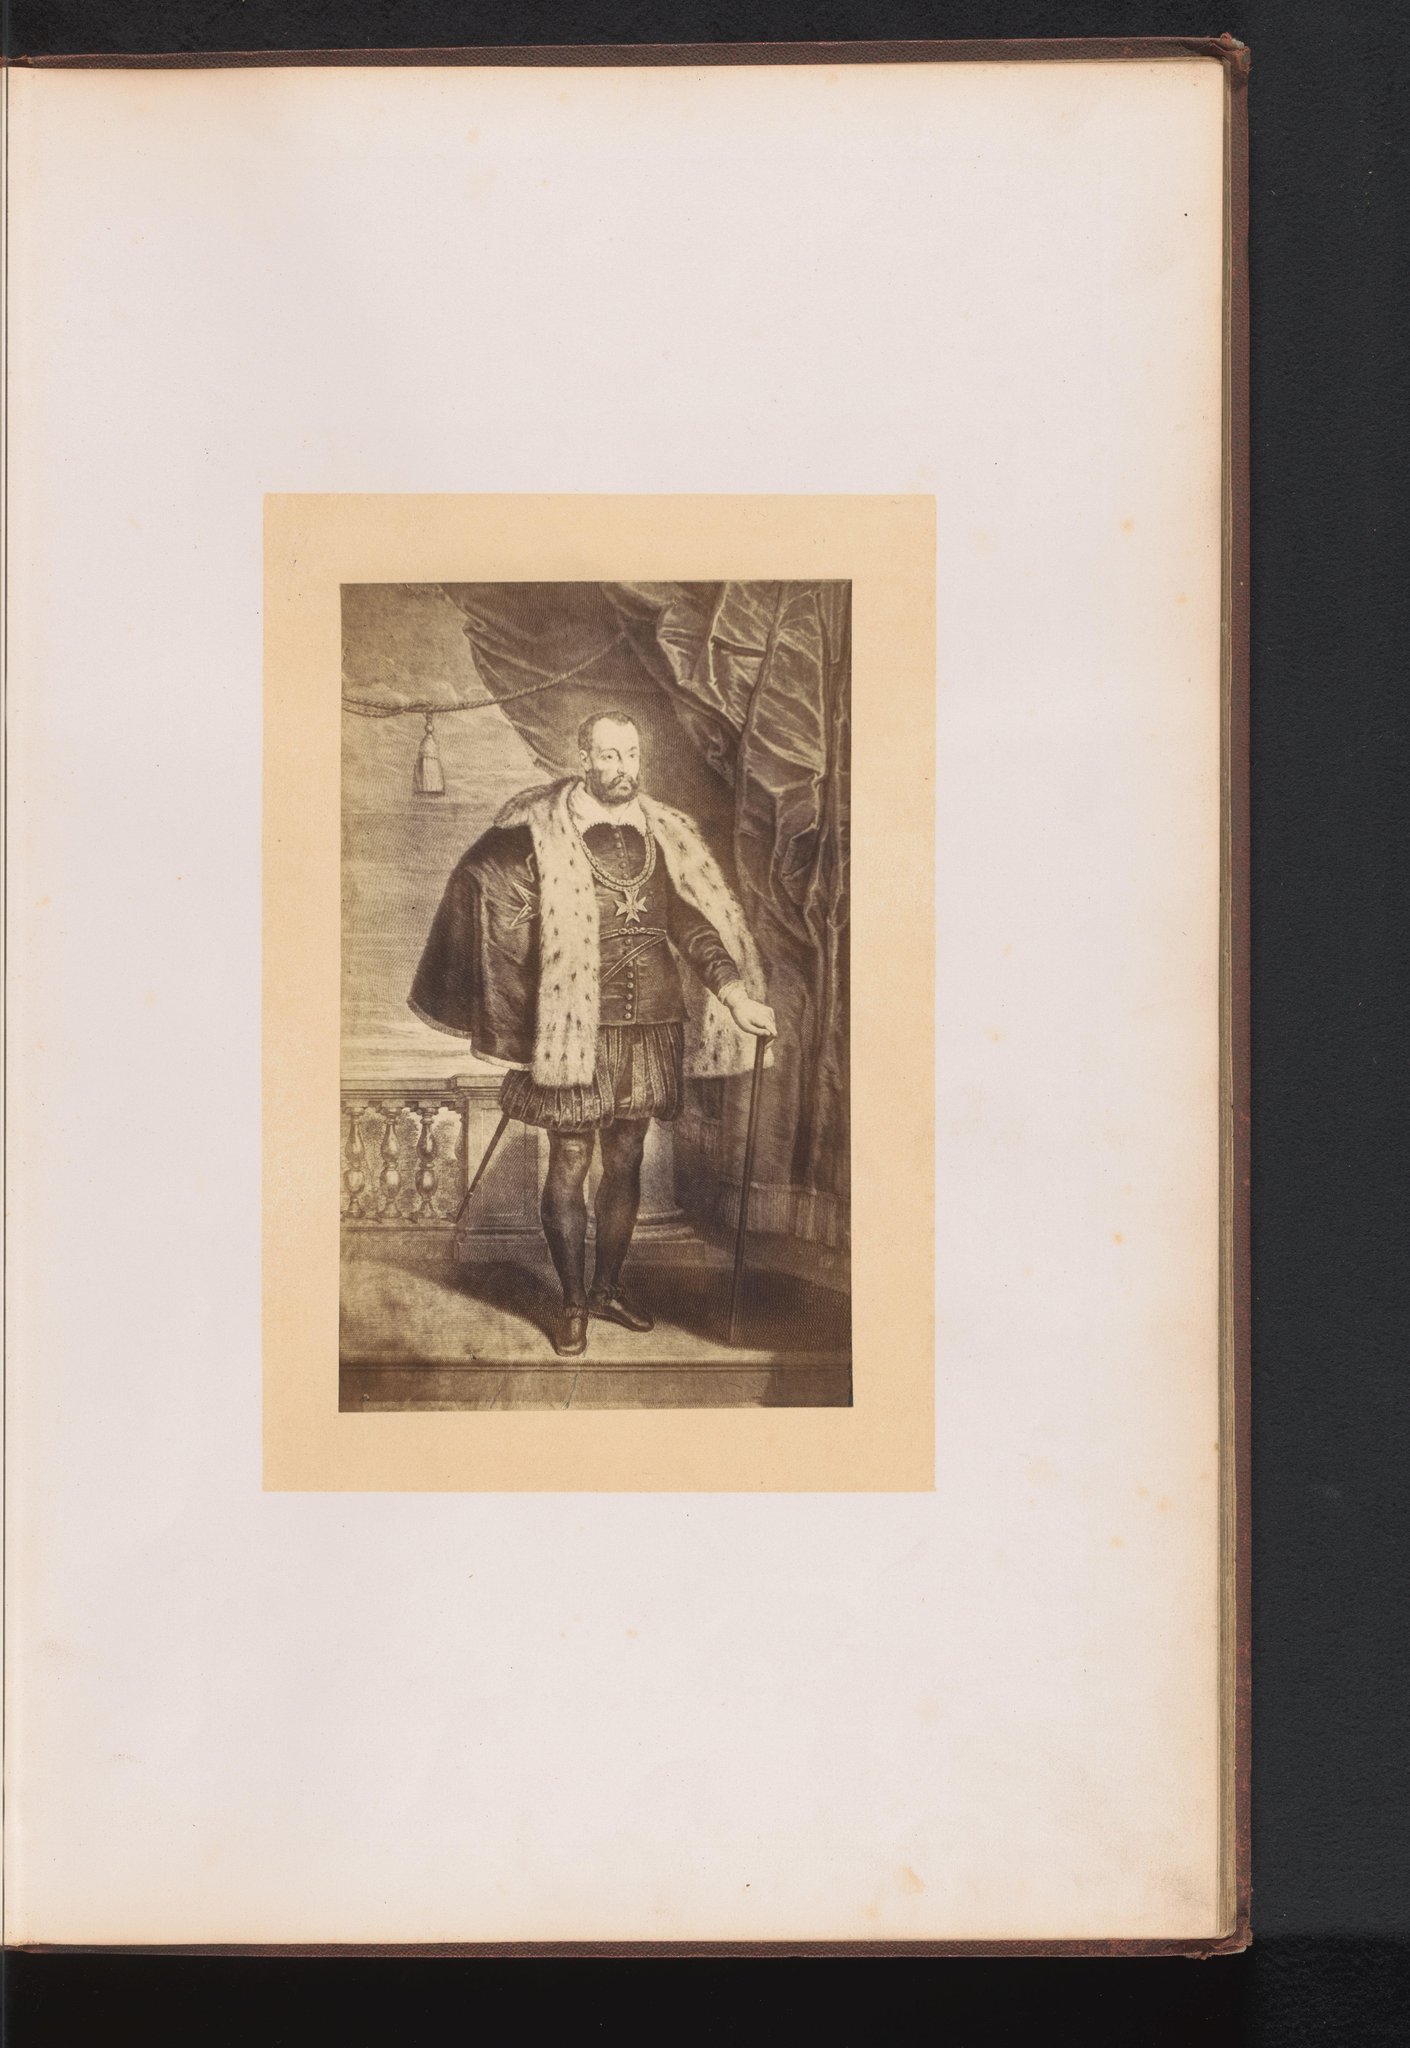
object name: photograph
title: Fotoreproductie van een gravure van een portret van Francesco I de'Medici door Jean-Marc Nattier, naar het schilderij door Peter Paul Rubens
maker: peter paul rubens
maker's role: draughtsman, painter, print maker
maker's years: 1577-1640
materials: photographic support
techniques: albumen print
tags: francesco i de' medici, aristocracy; 'aristocratia' (ripa), historical persons